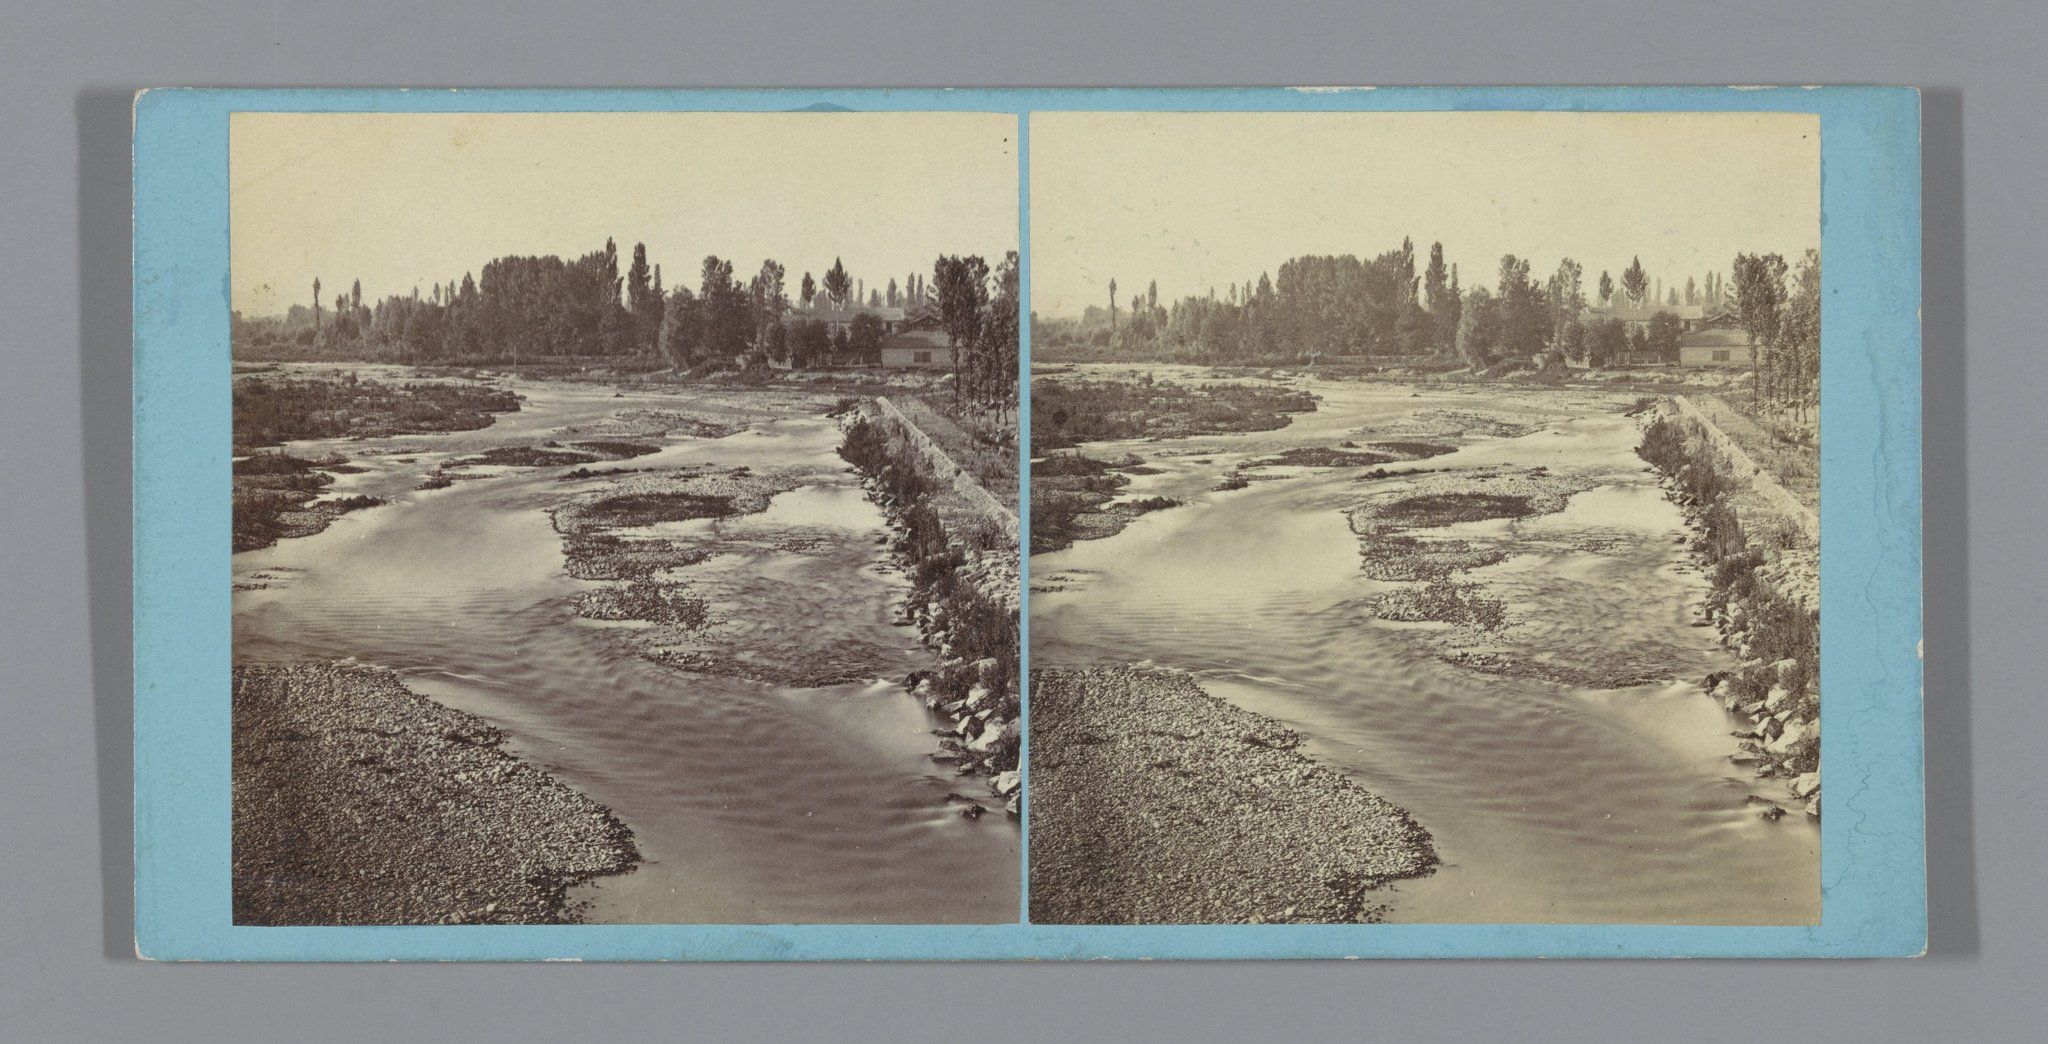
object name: stereograph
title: Gezicht op de Adour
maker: Anonymous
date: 1860-1880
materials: cardboard, photographic support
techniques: albumen print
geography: france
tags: river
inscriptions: title: ‘l'Adour, prise du pont, Tarbes’